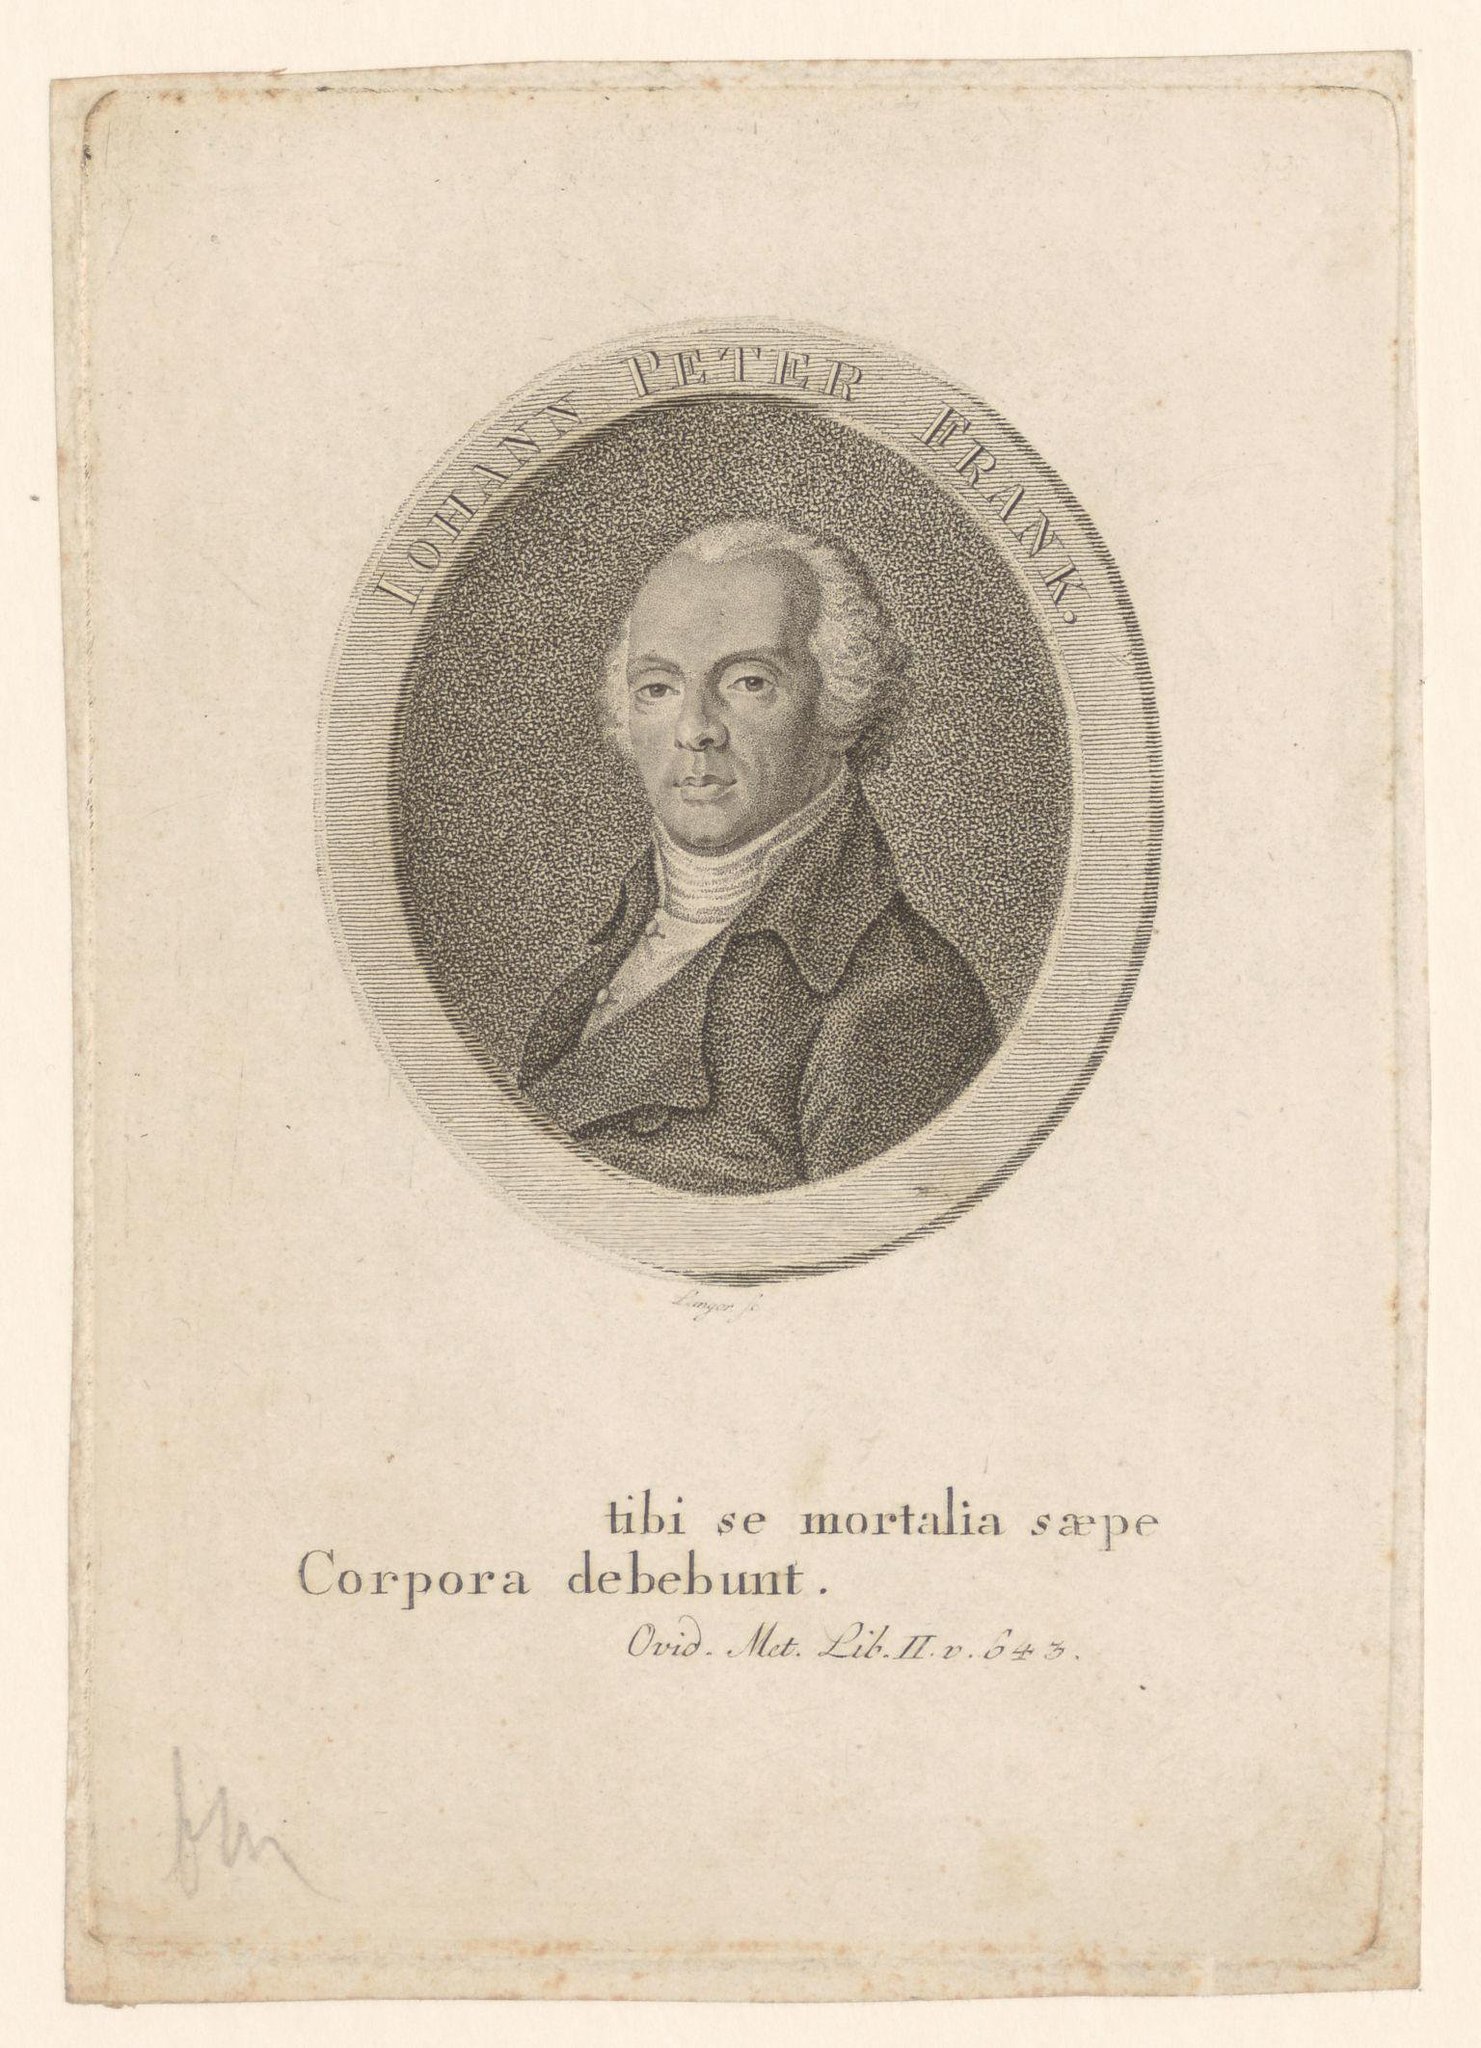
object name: print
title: Portret van Johann Peter Frank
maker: sebastian langer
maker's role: print maker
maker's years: 1772-1841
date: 1782-1841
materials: paper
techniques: etching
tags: further education (+ portrait of teacher, professor), historical persons, physician, doctor (+ portrait of scholar, scientist)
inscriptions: collector's mark: Lugt 2228